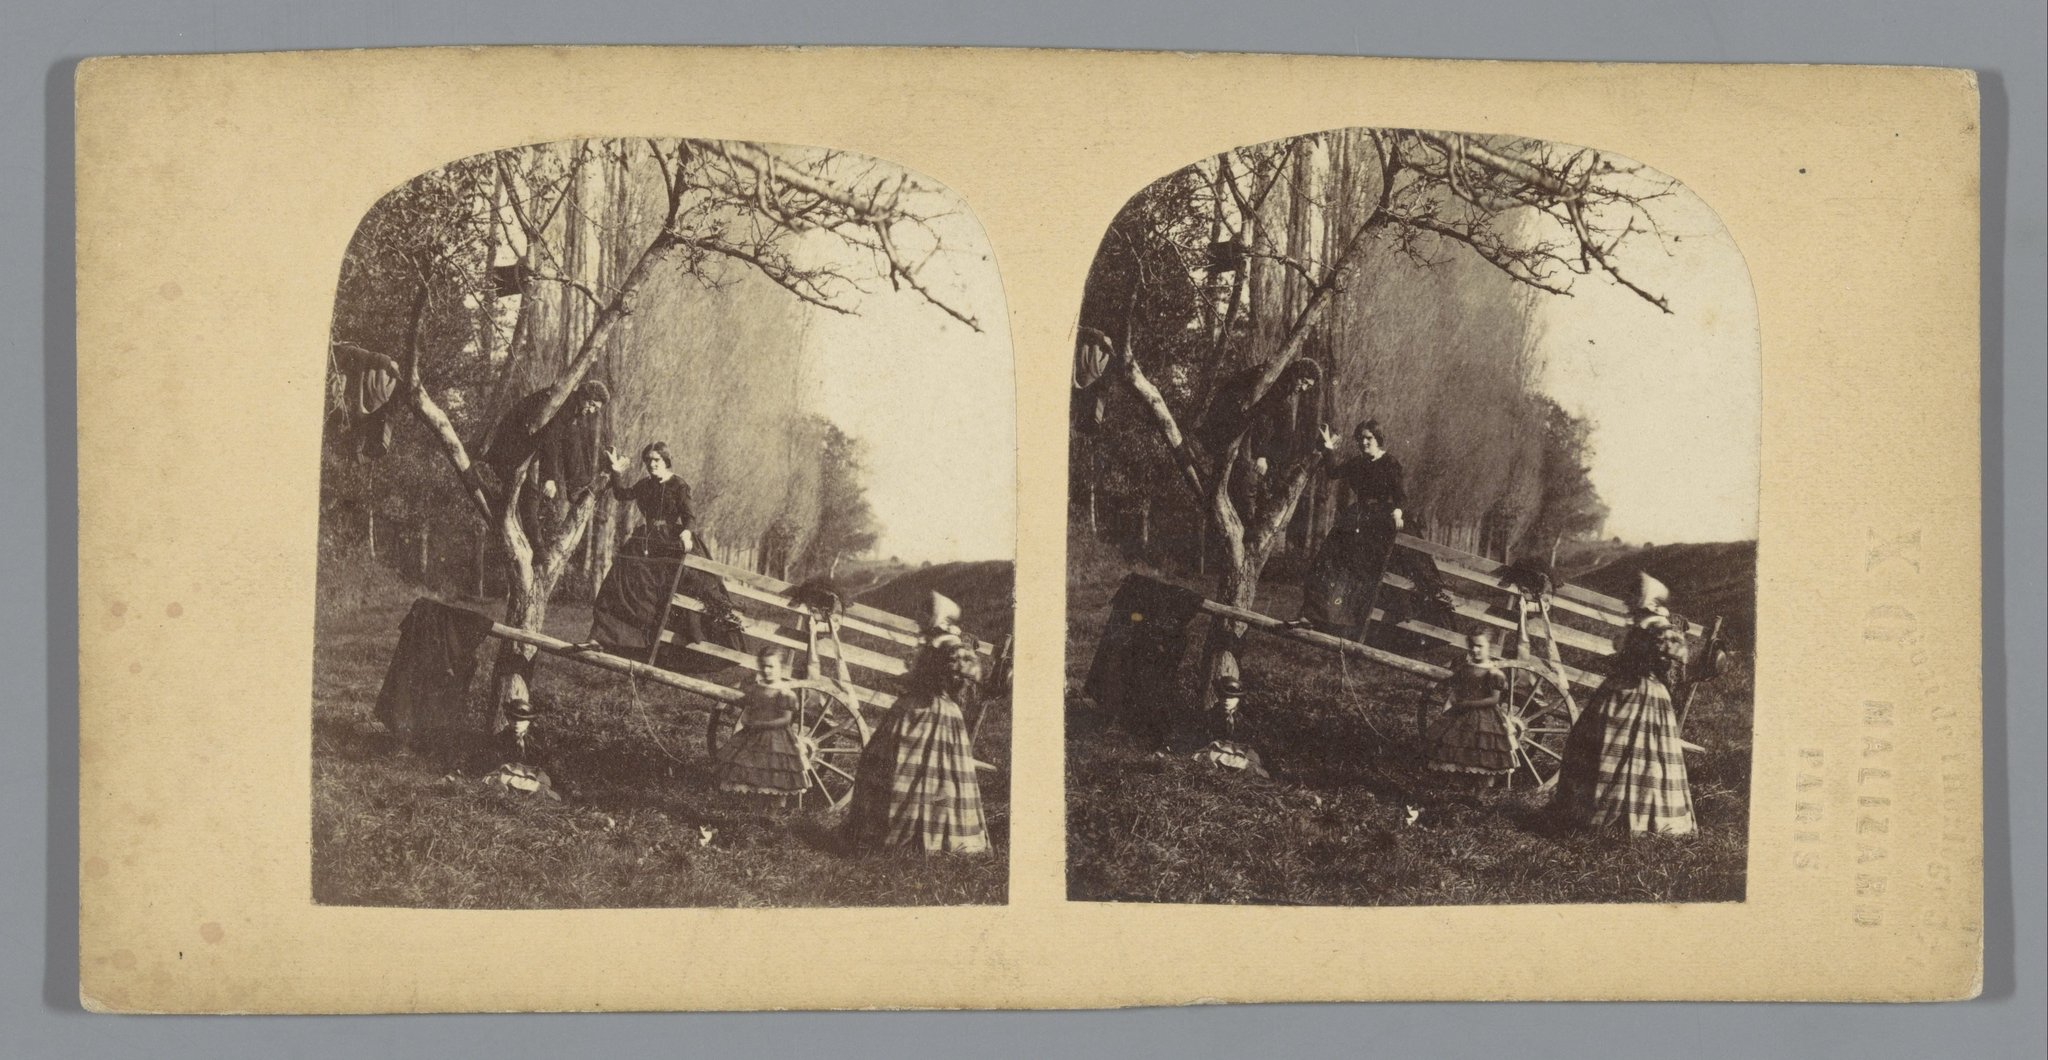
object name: stereograph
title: Man klimt in boom voor hoed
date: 1857-1870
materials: cardboard, paper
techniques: albumen print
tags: head-gear: hat